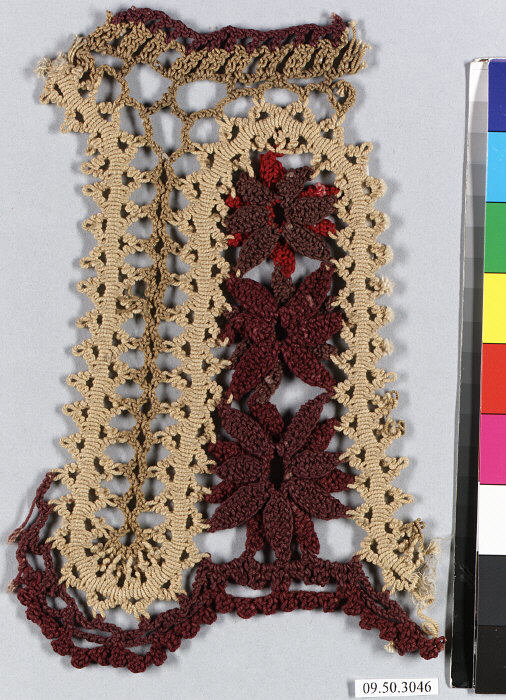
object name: sample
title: Crochet Work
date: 1801-1900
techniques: crochet